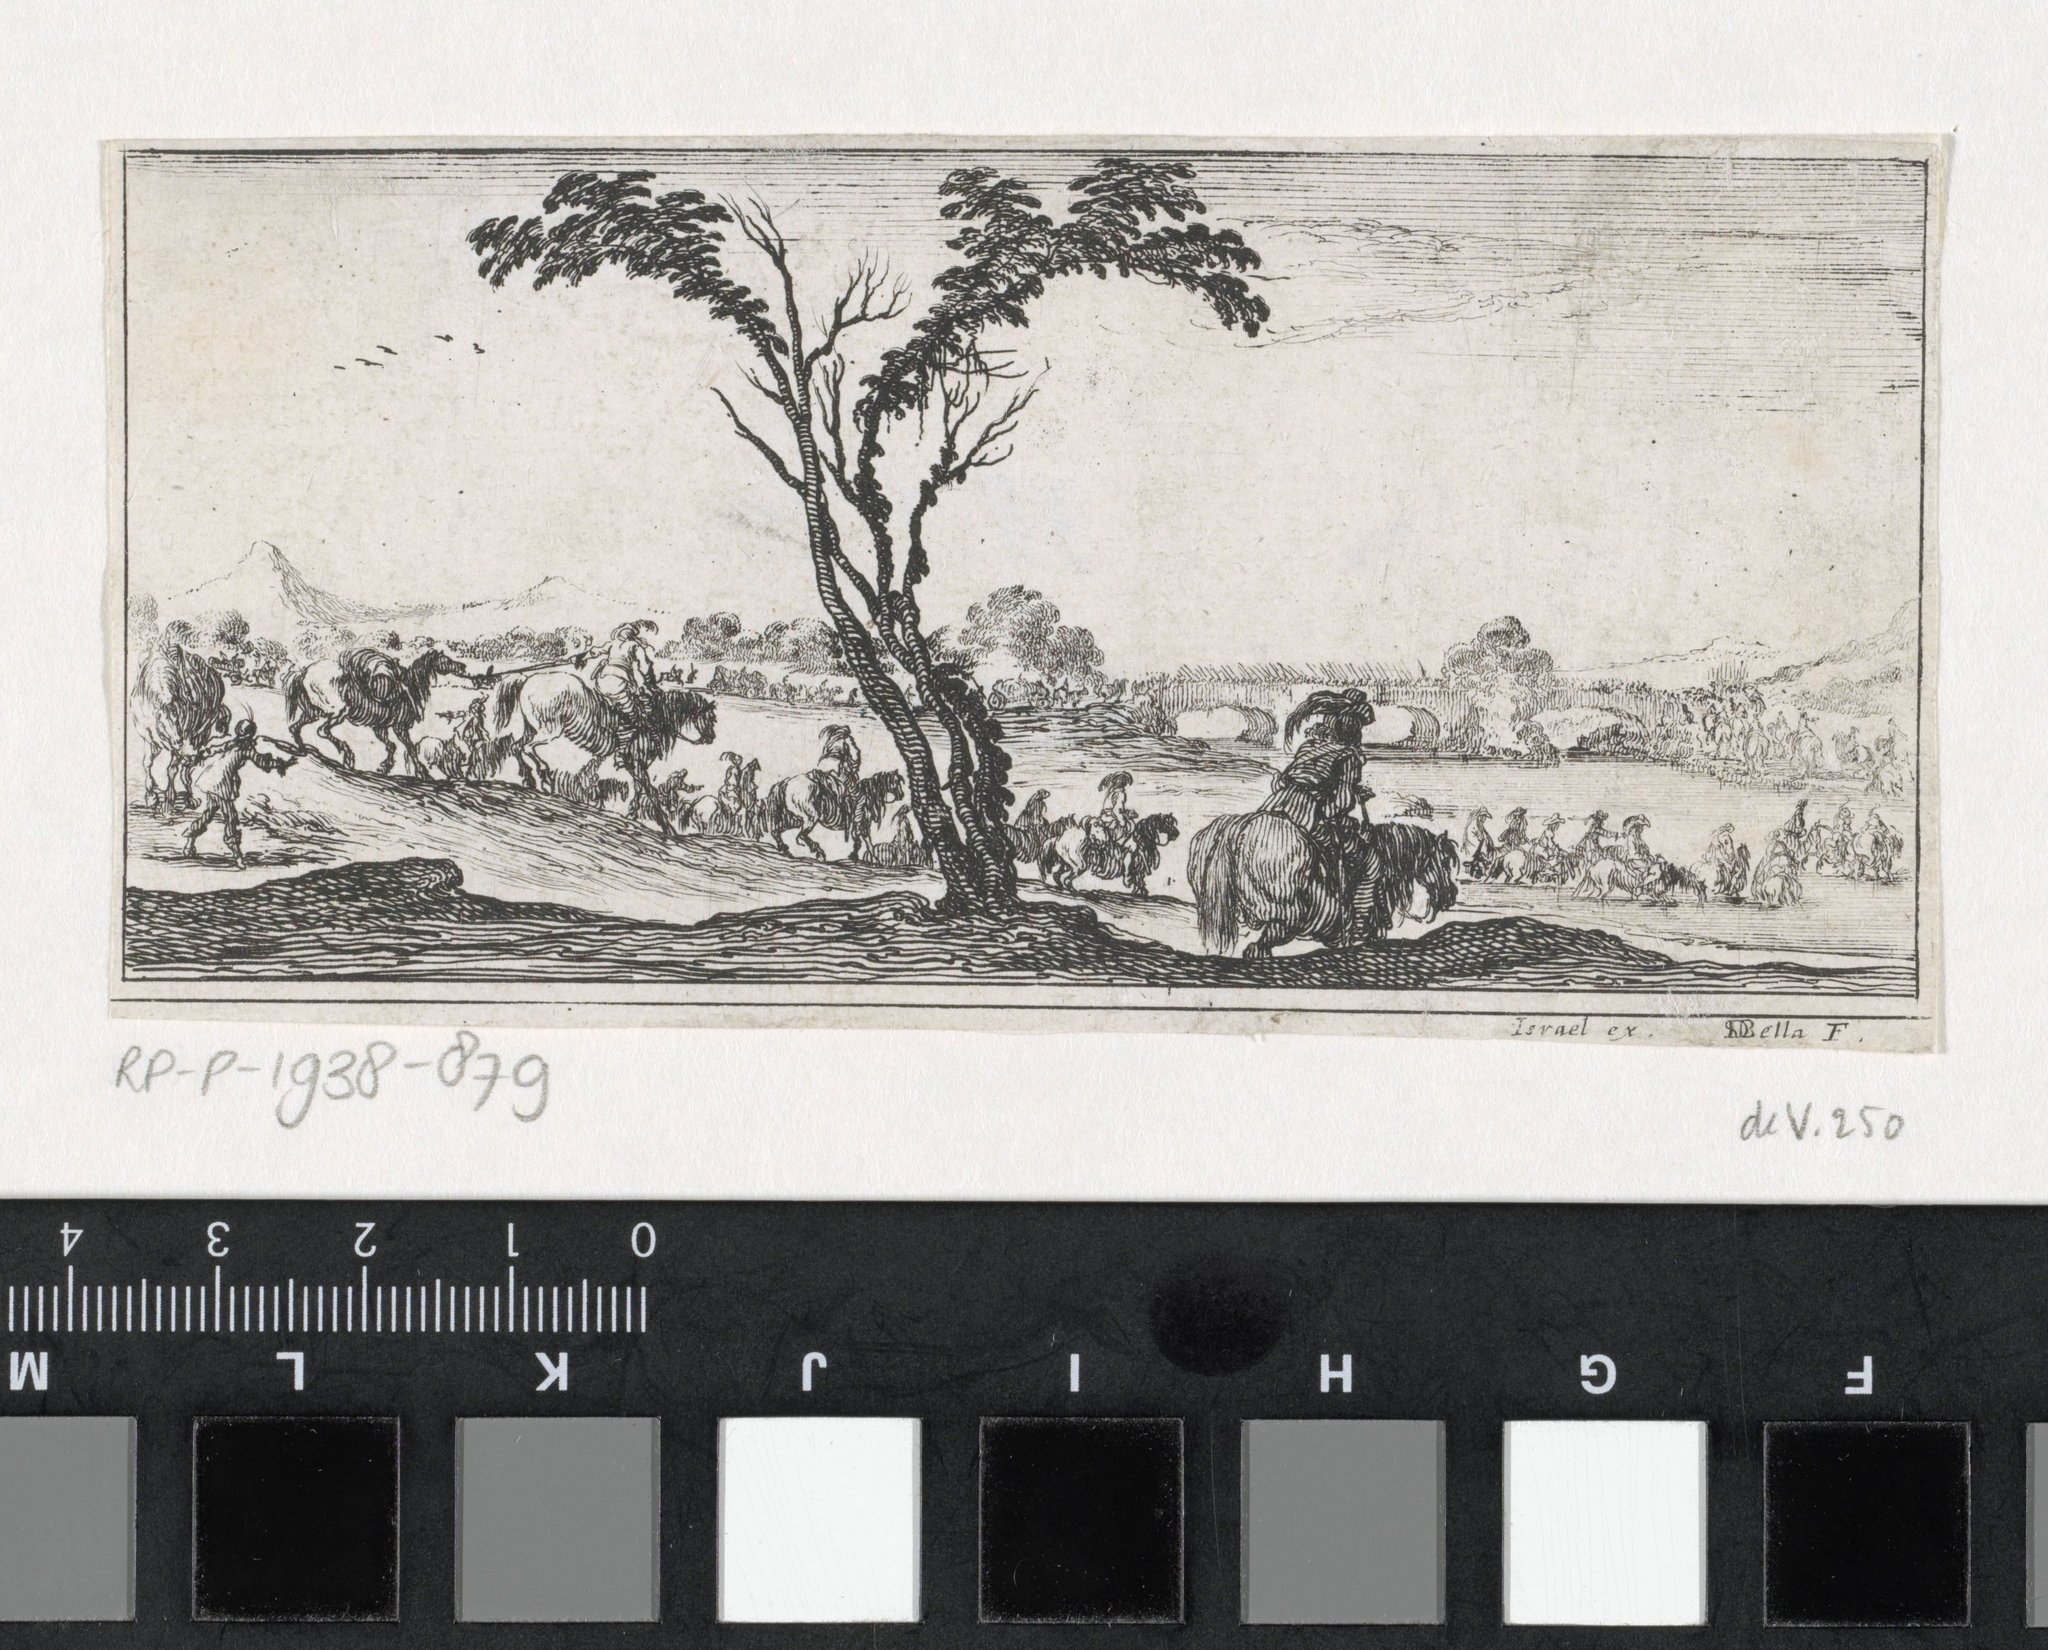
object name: print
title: Desseins de quelques conduites de troupes, canons, et ataques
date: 1620-1664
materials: paper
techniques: etching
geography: france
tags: crossing a river, riding a horse, ass, or mule; rider, horseman, horse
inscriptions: collector's mark: Lugt 2228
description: Een stoet van mannen te paard loopt langs een rivier en steekt rechts de rivier over. Midden voor een boom.